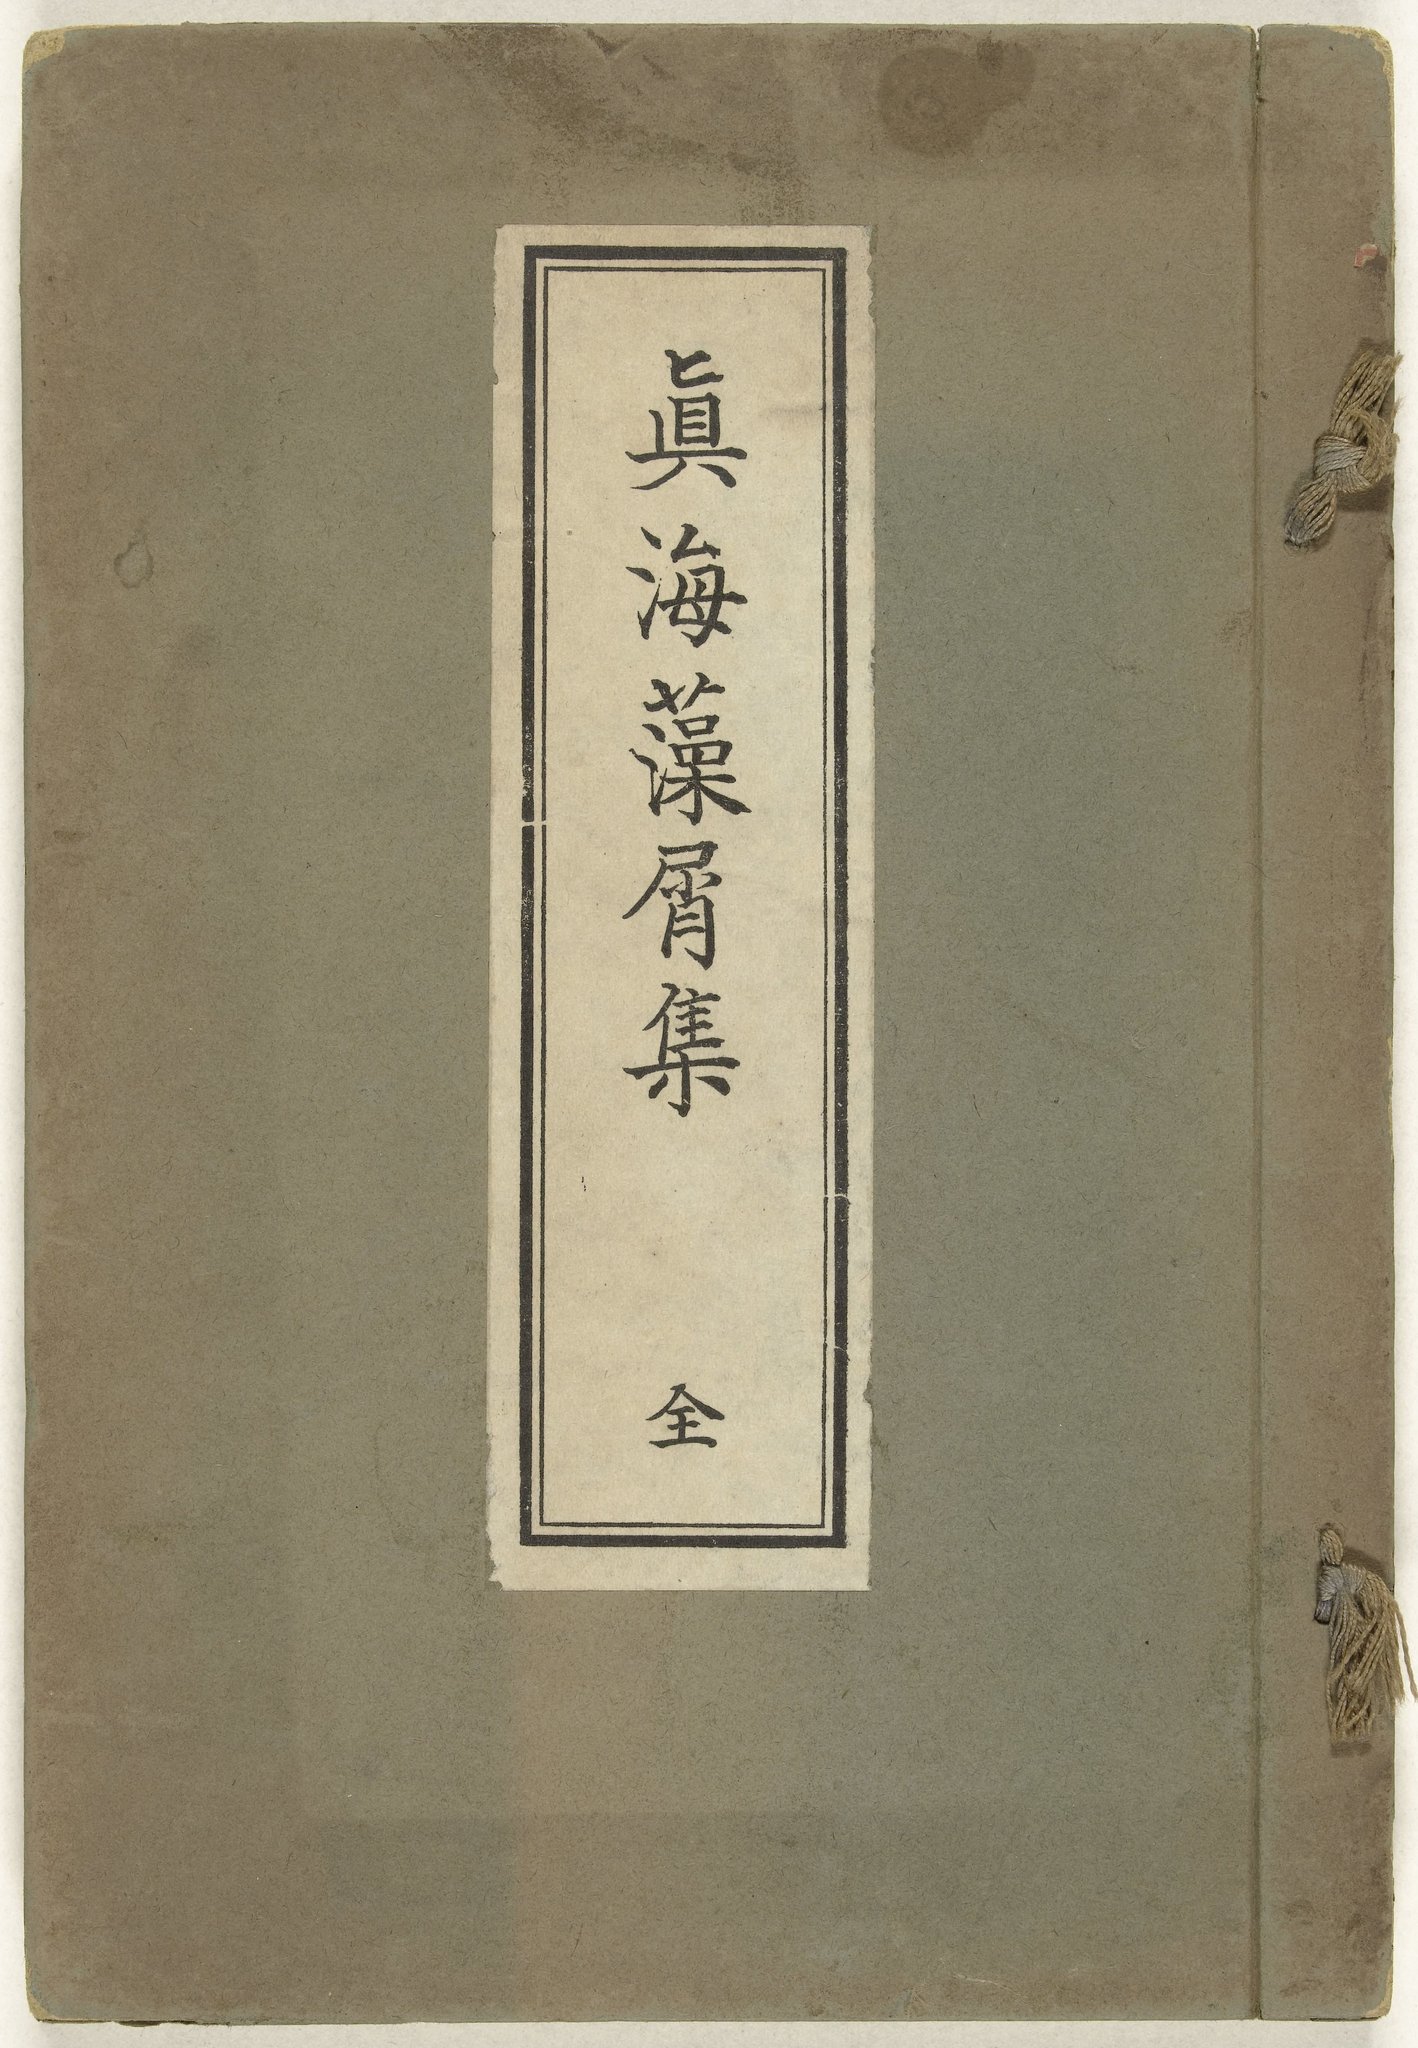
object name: book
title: Complete verzameling geschriften van Shinkai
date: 1911-1923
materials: paper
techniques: woodcut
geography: japan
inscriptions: date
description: Zie voor vergelijkbare exemplaren RP-P-2005-536 en 555.